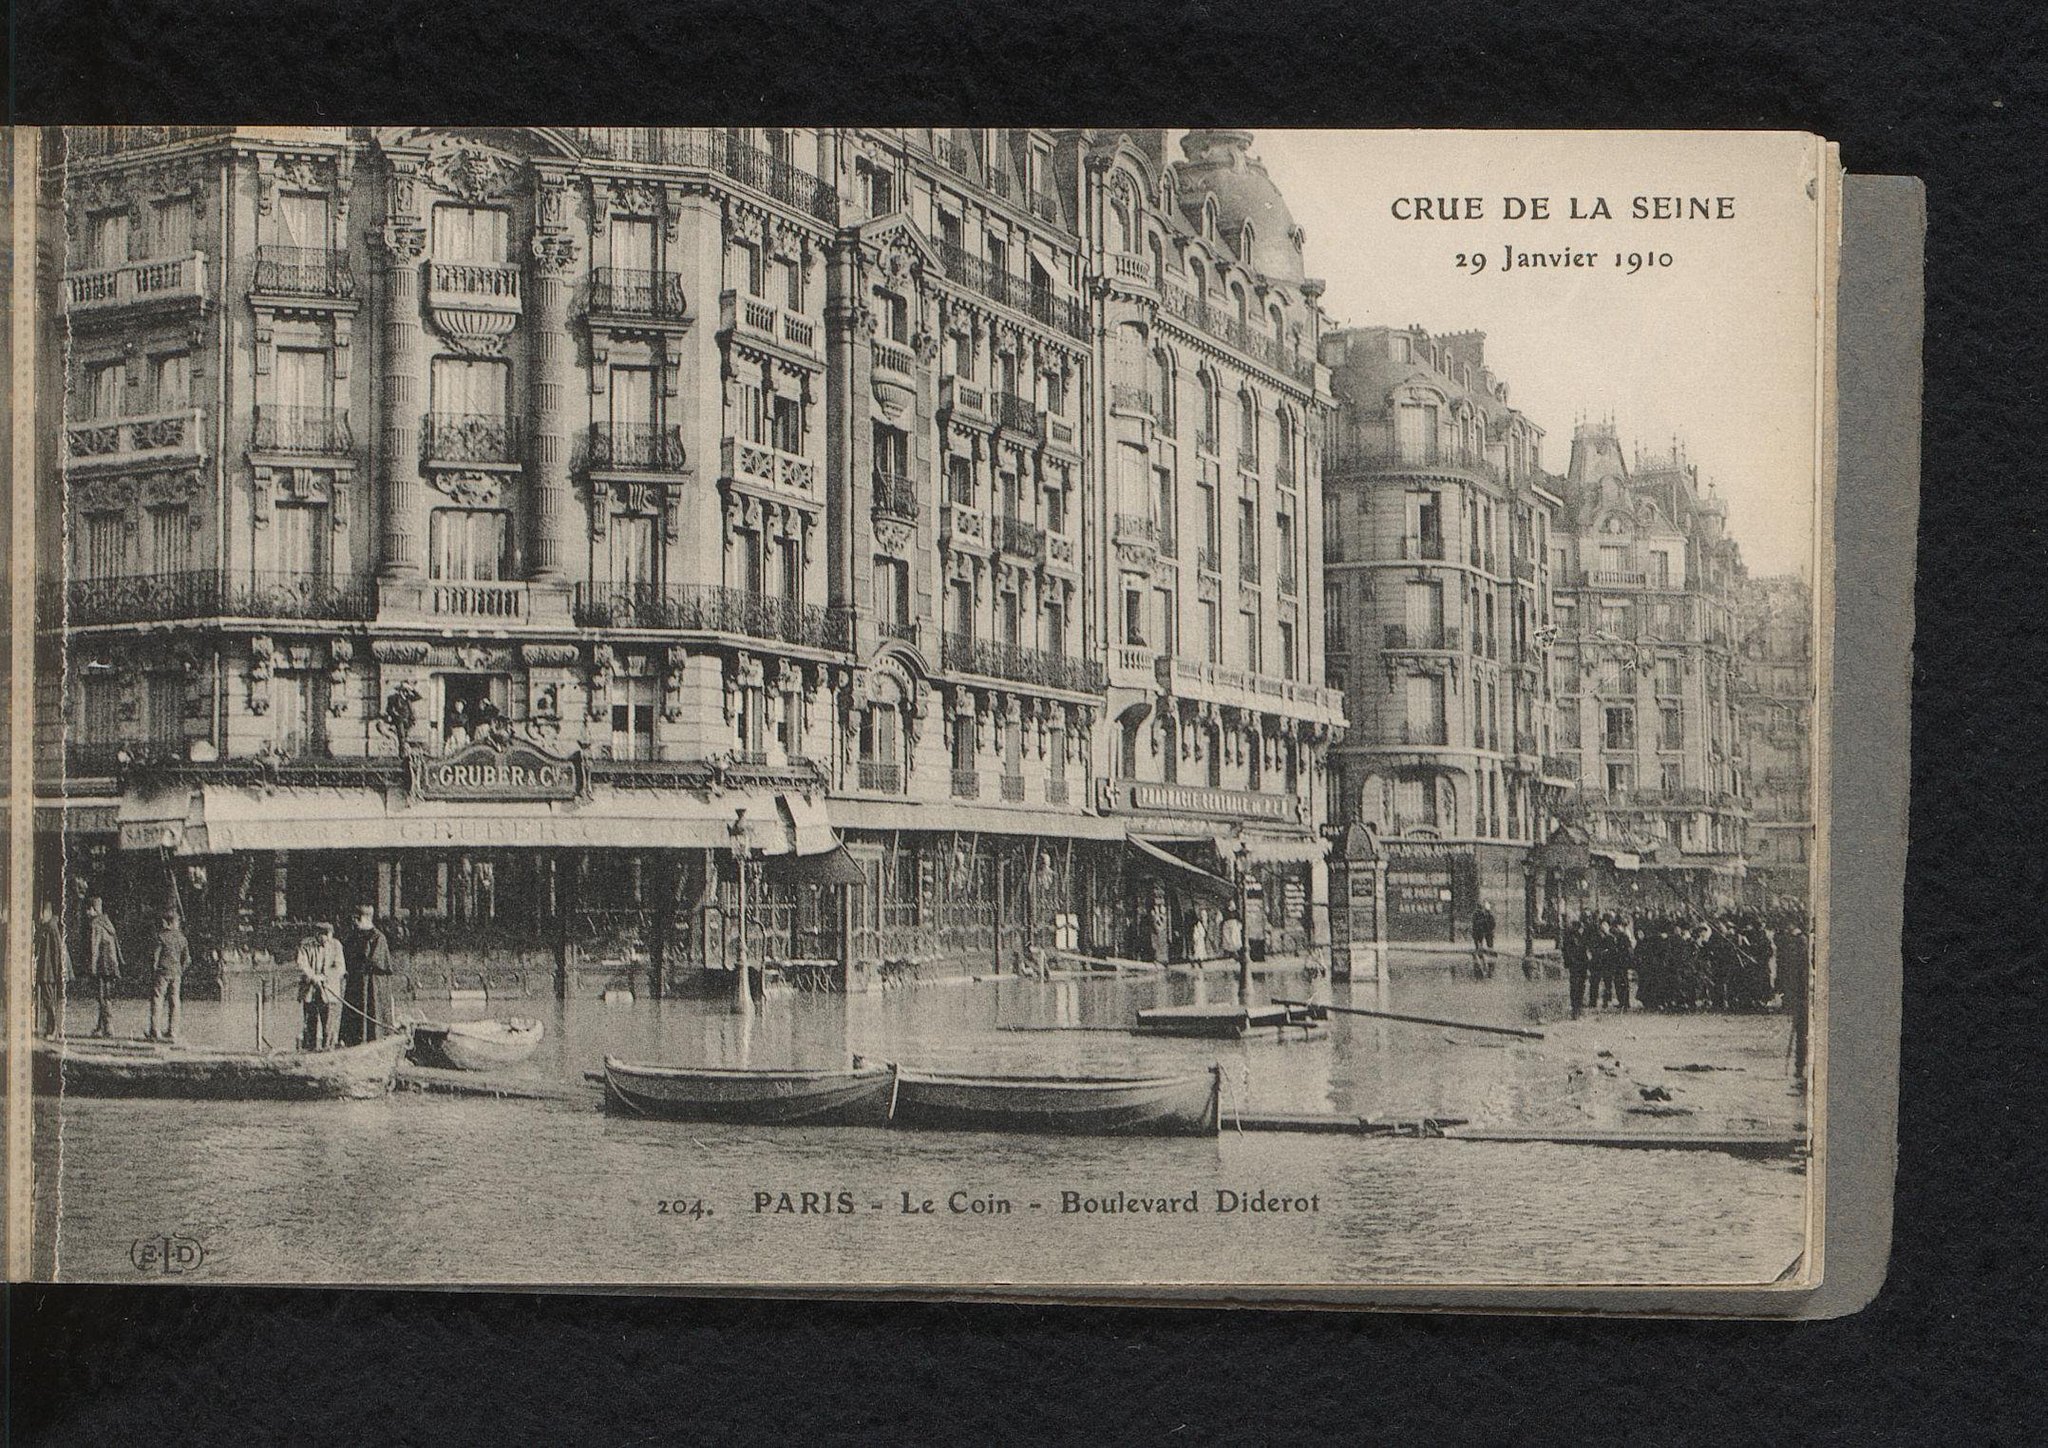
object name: ansichtkaart, prentbriefkaart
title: Crue de la Seine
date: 1910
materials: cardboard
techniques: photograph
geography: paris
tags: rowing-boat, canoe, etc., flood, city-view, and landscape with man-made constructions (+ city(-scape) with figures, staffage), paris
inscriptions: date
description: Prentbriefkaart maakt deel uit van een album.